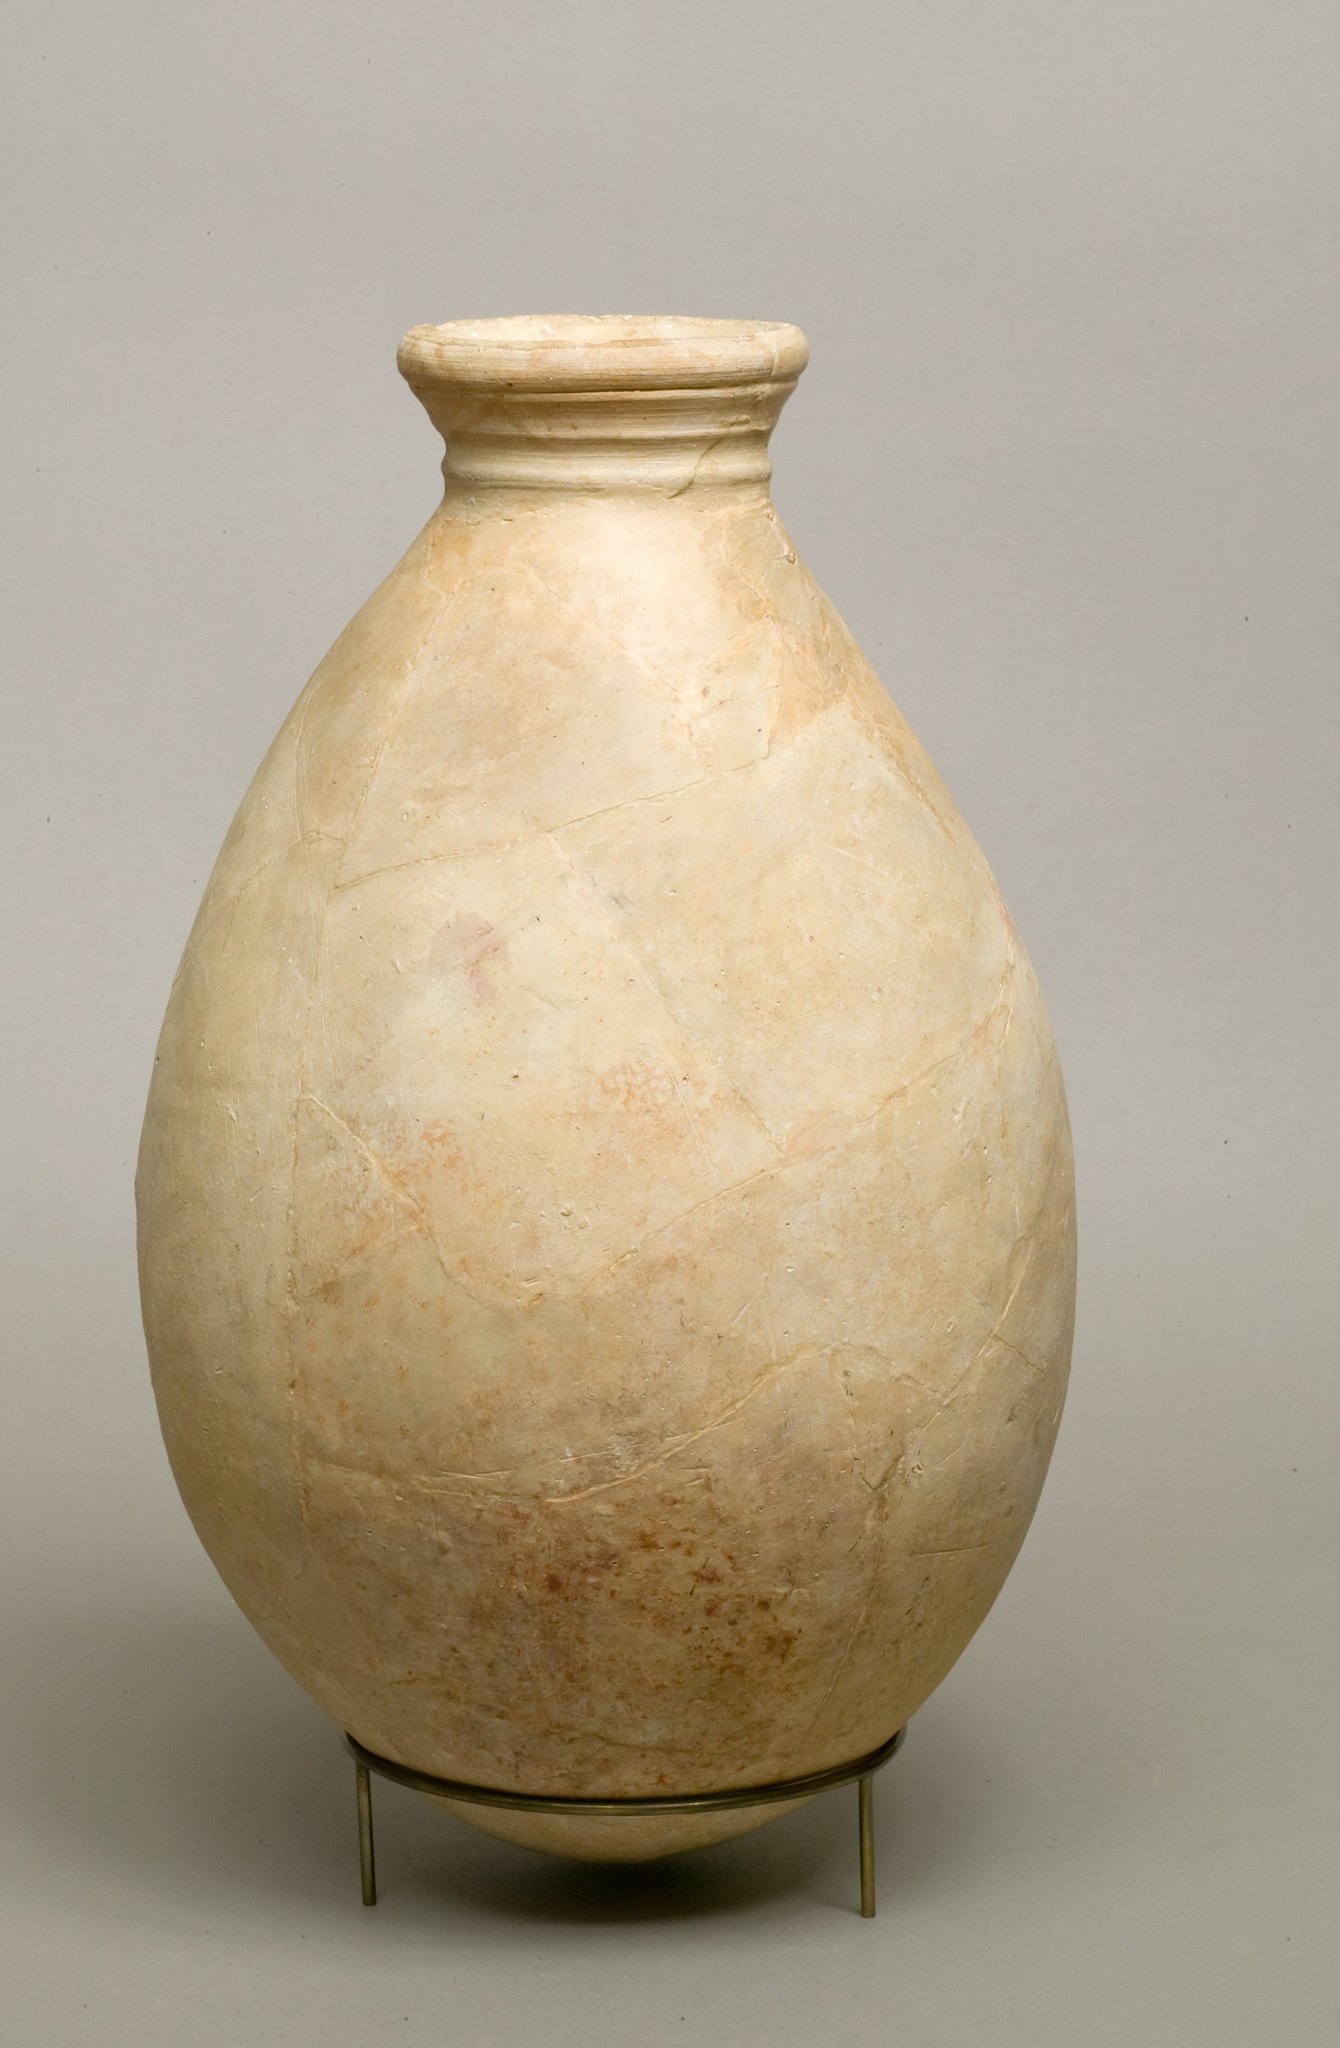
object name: jar, water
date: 1859-1749 BCE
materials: pottery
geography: egypt